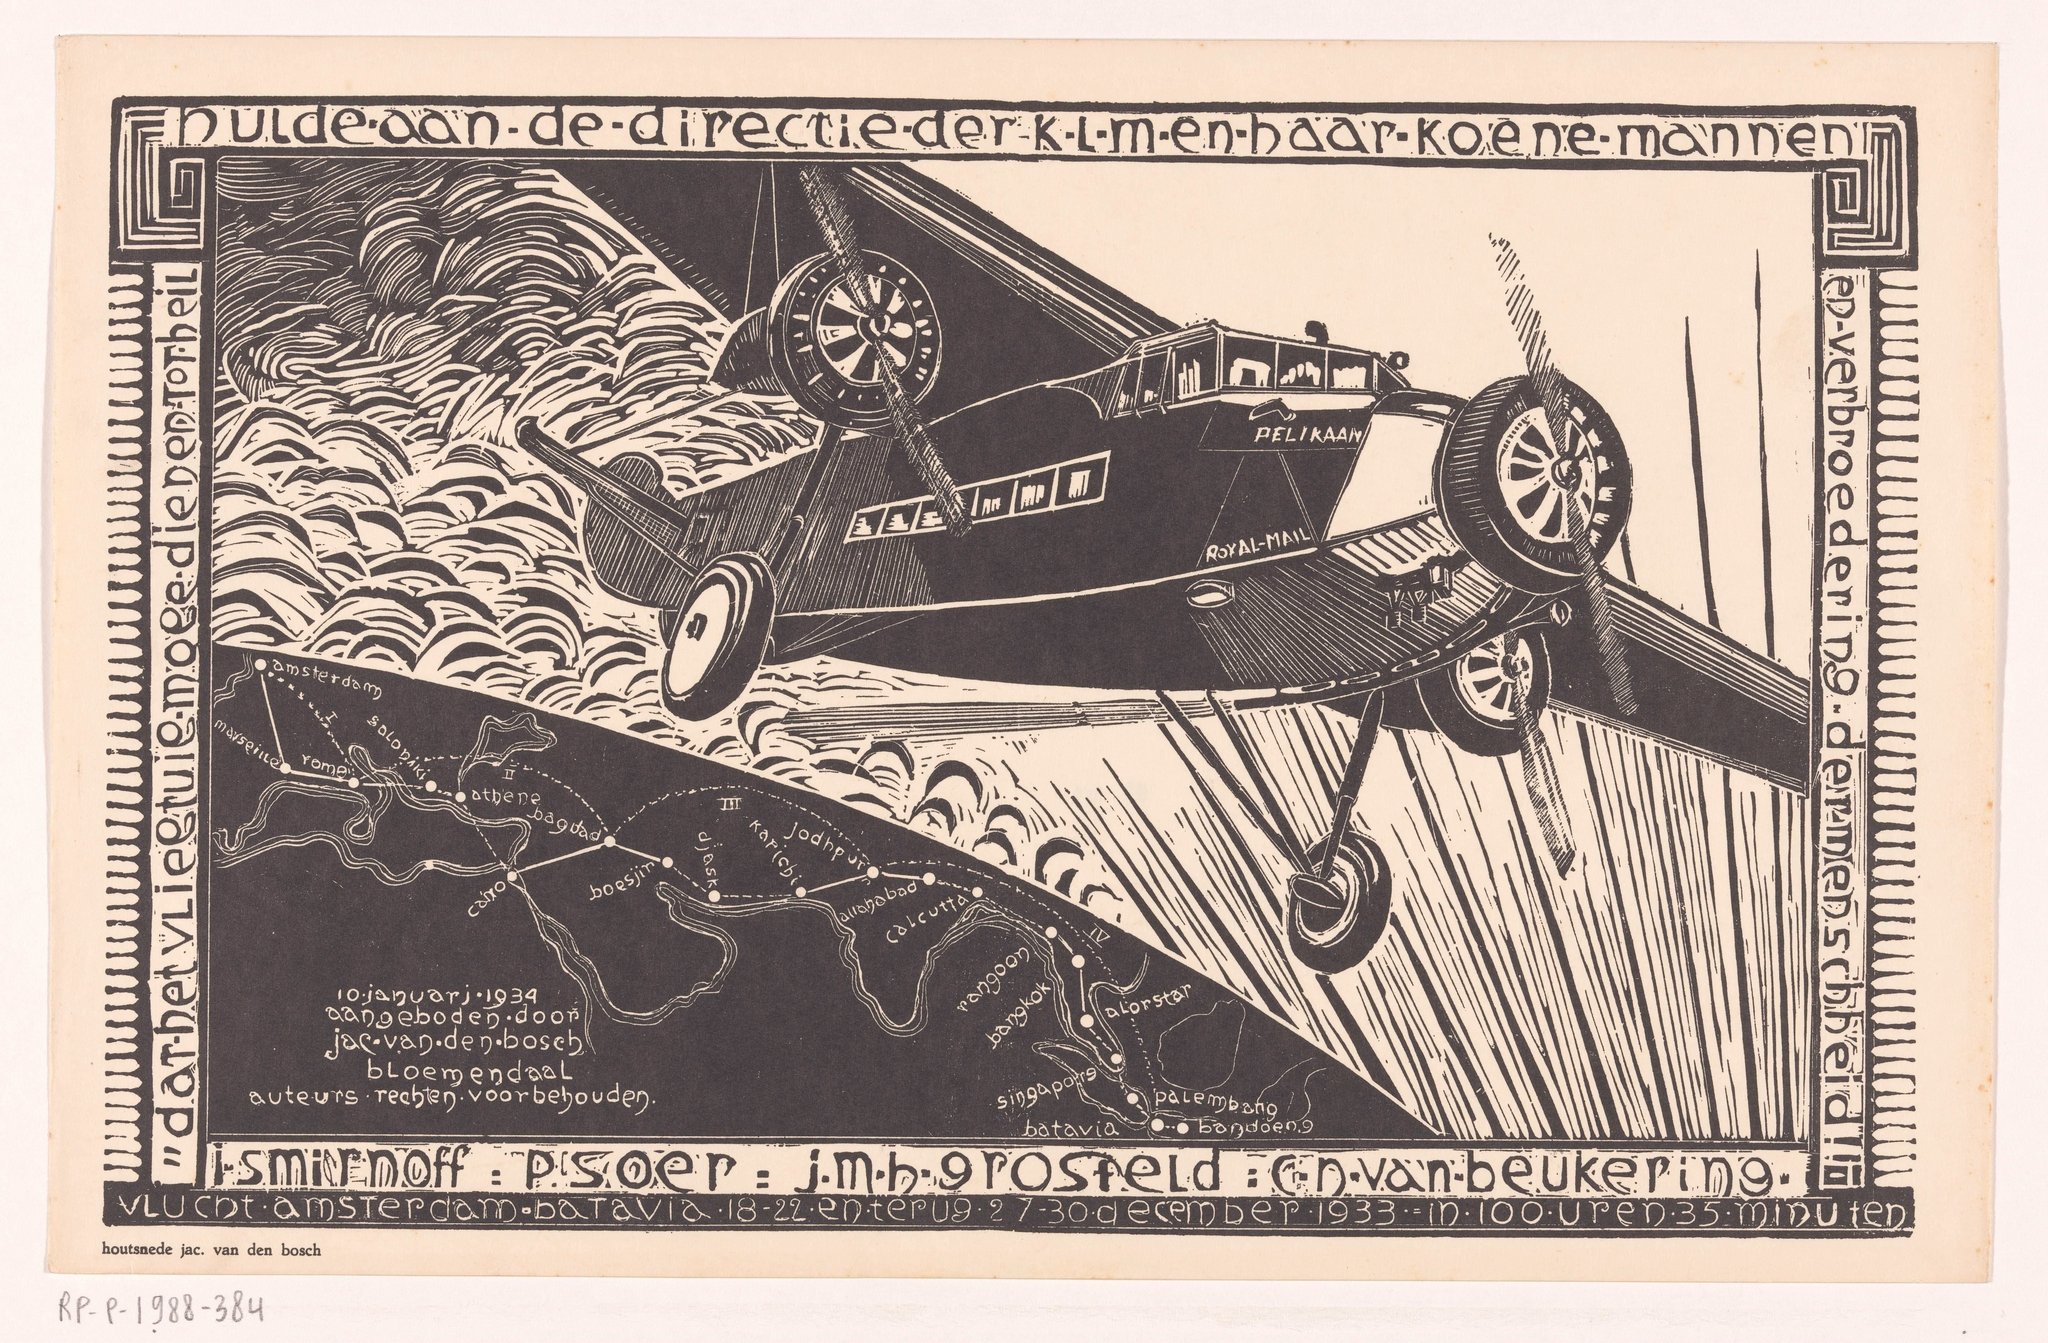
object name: print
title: Vlucht van de Pelikaan van Amsterdam naar Batavia in 1933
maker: jacob pieter van den bosch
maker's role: draughtsman, print maker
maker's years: 1868-1948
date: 1934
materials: paper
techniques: woodcut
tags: maps of separate countries or regions, aircraft, aeroplane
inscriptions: : ‘Hulde aan de directie der KLM en haar koene mannen / I. Smirnoff, P. Soer, J.M.H. Grosfeld, C.N. van Beukering / dat het vliegtuig moge dienen tot heil / en verbroedering der mensheid’, inscription: ‘Present Etc / niet voor den handel / Jac. vdB’, collector's mark: Lugt 2228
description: Het vliegtuig de Pelikaan vliegend boven een plattegrond waarop de route Amsterdam-Batavia is gemarkeerd.